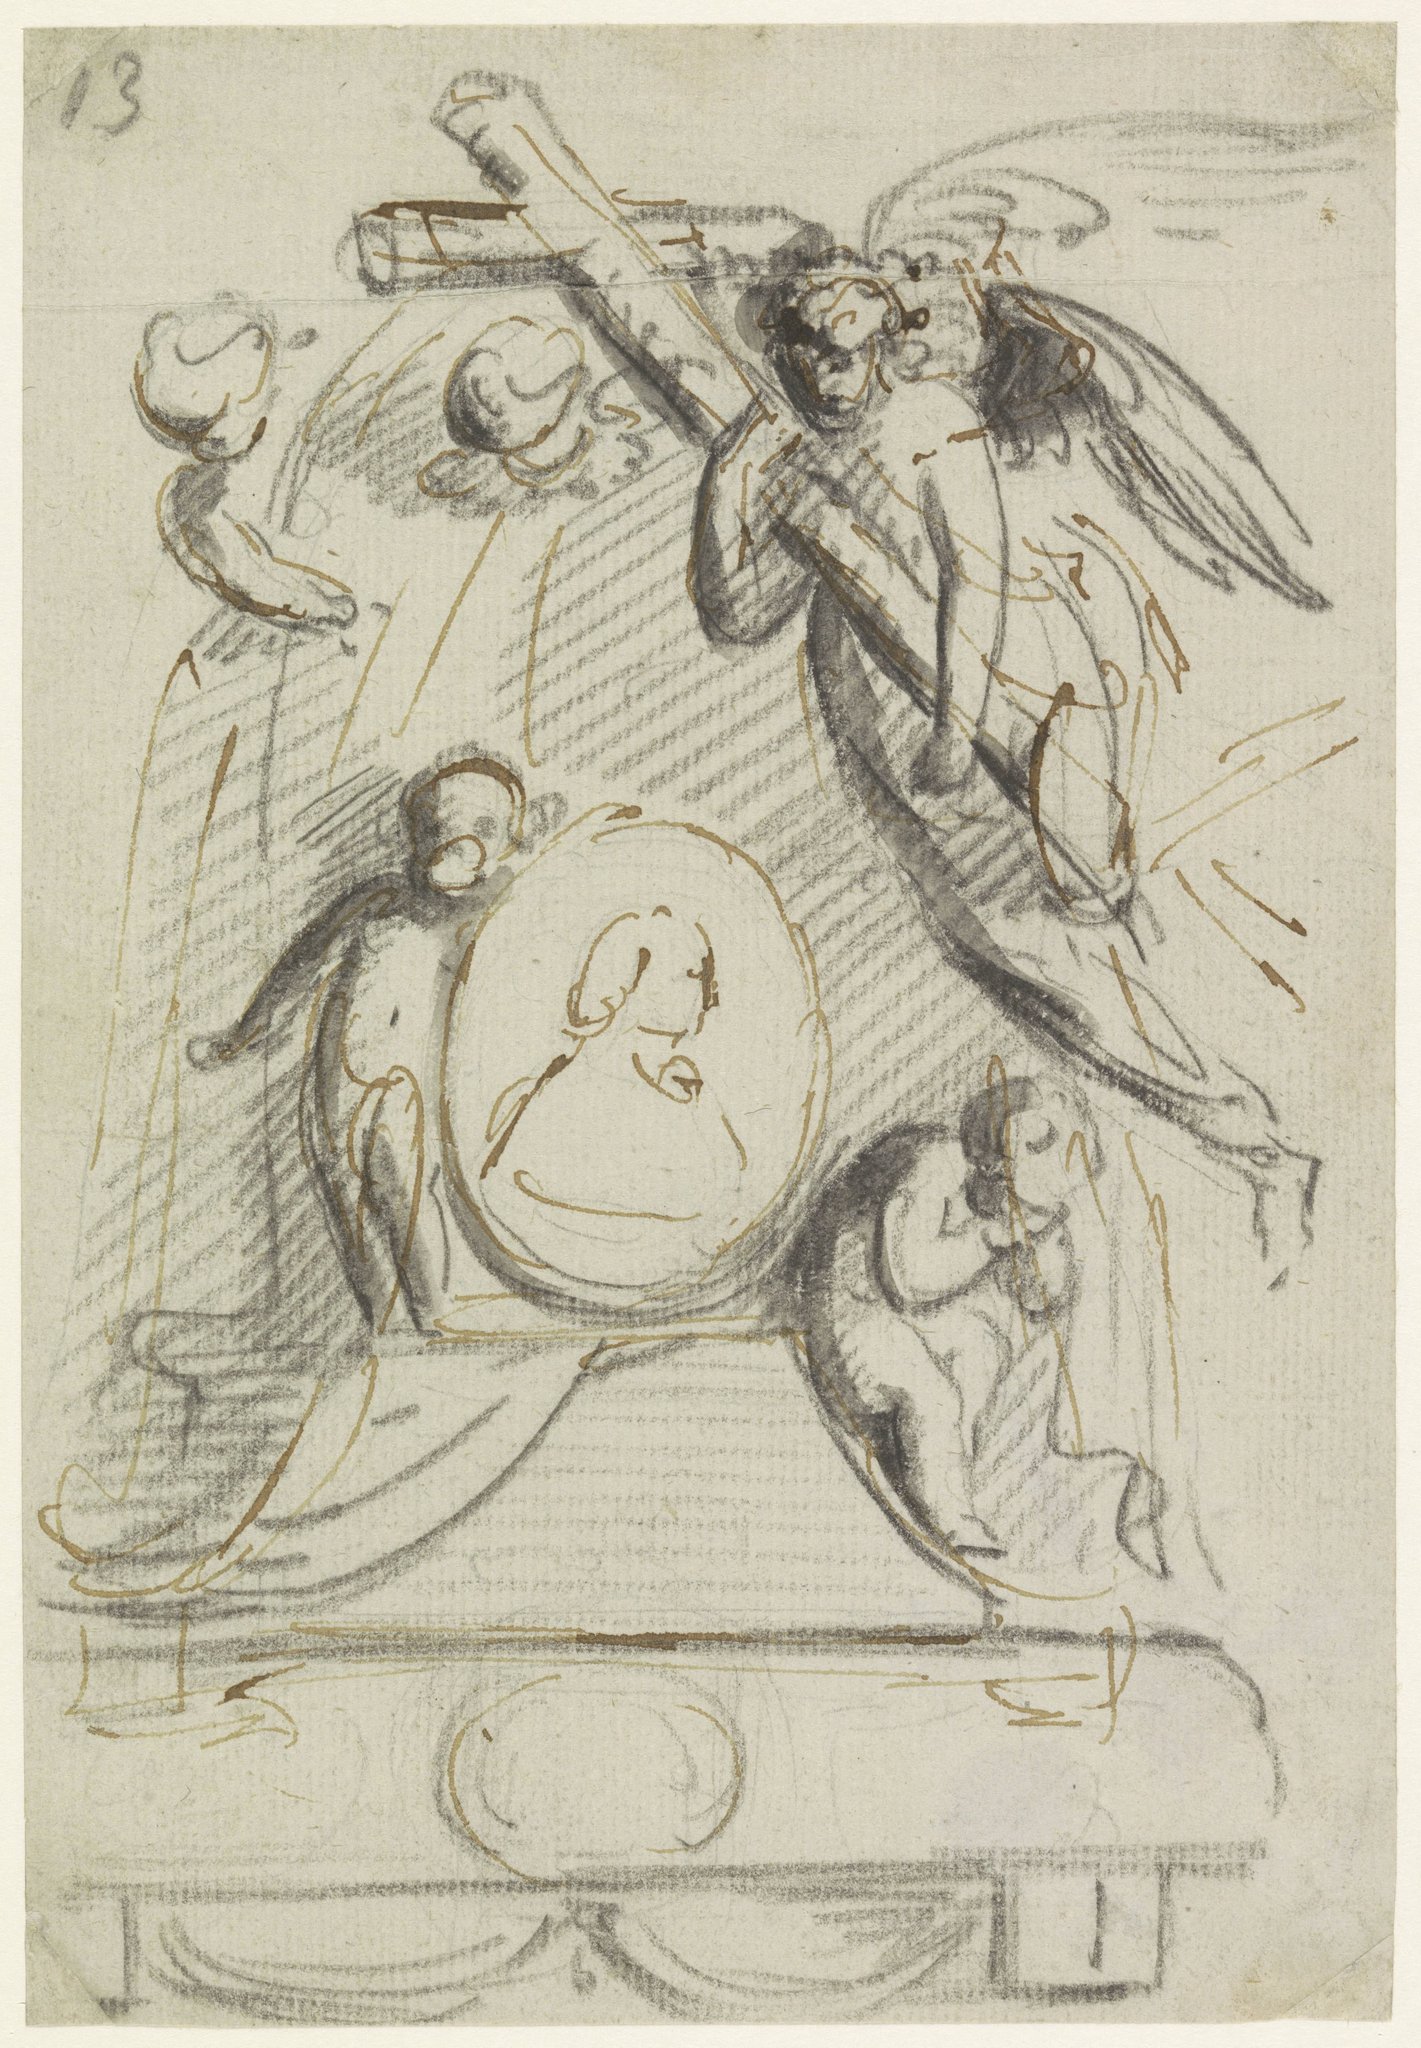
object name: design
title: Ontwerp voor een grafmonument voor een abt of bisschop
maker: Anonymous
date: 1700-1800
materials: chalk, ink, paper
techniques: brush, pen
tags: grave-building, monumental tomb